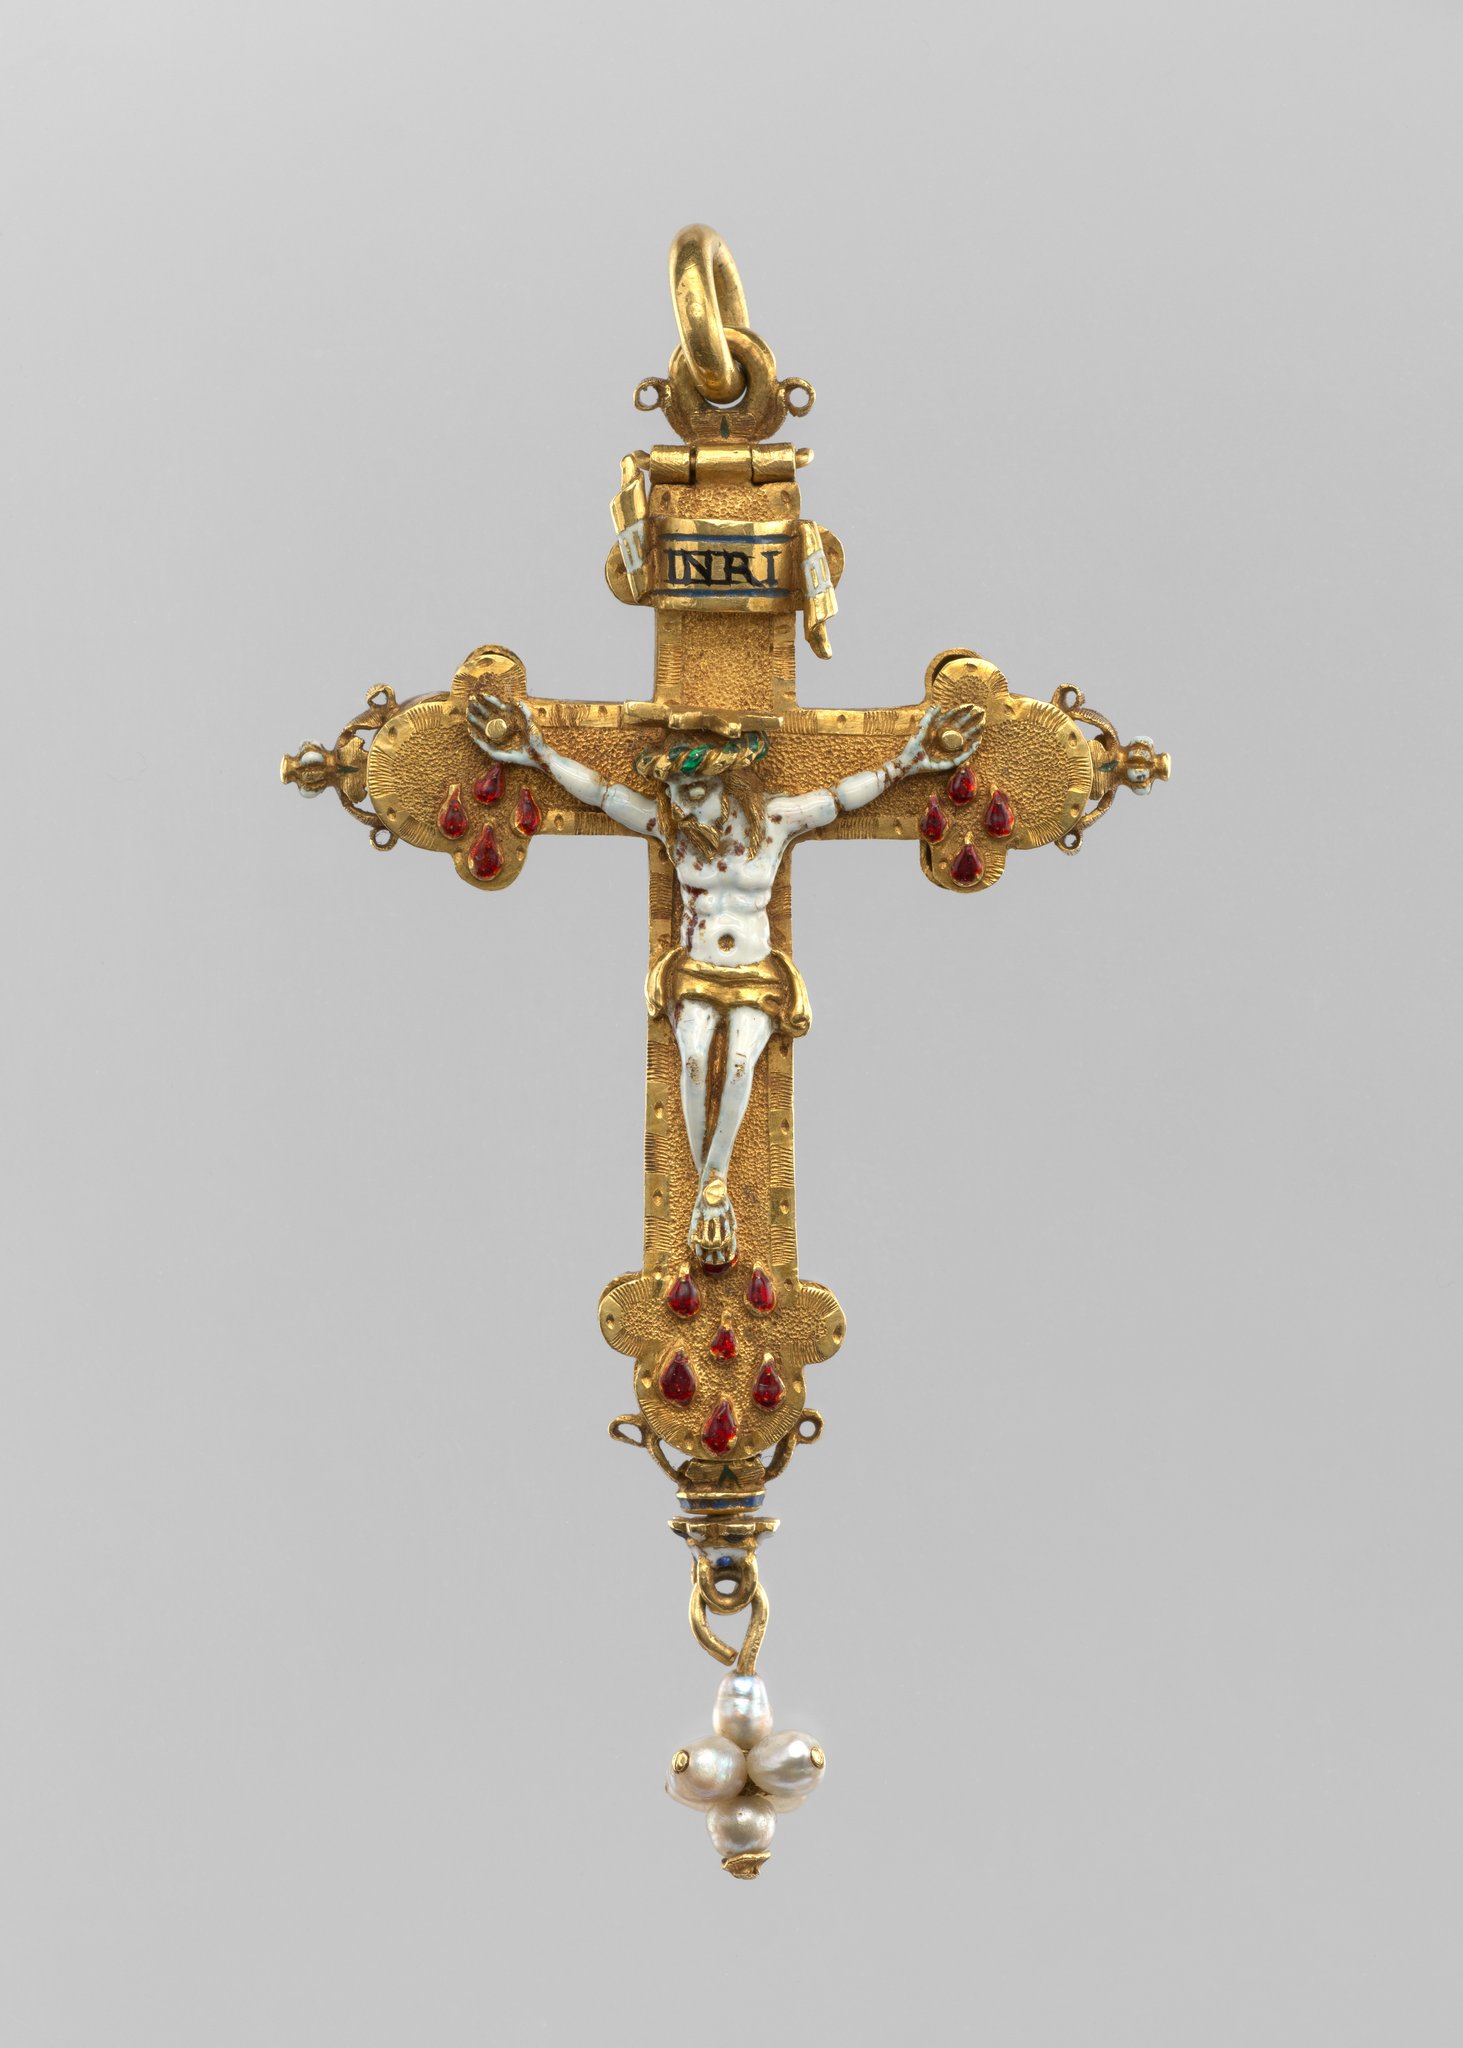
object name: pendant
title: Reliquary crucifix pendant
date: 1601-1800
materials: enamel, gold, pearl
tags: christ,crucifixion